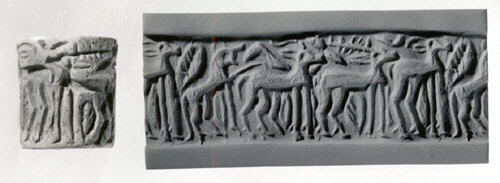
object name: cylinder seal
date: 2900-2700 BCE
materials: bone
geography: mesopotamia or syria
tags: animals